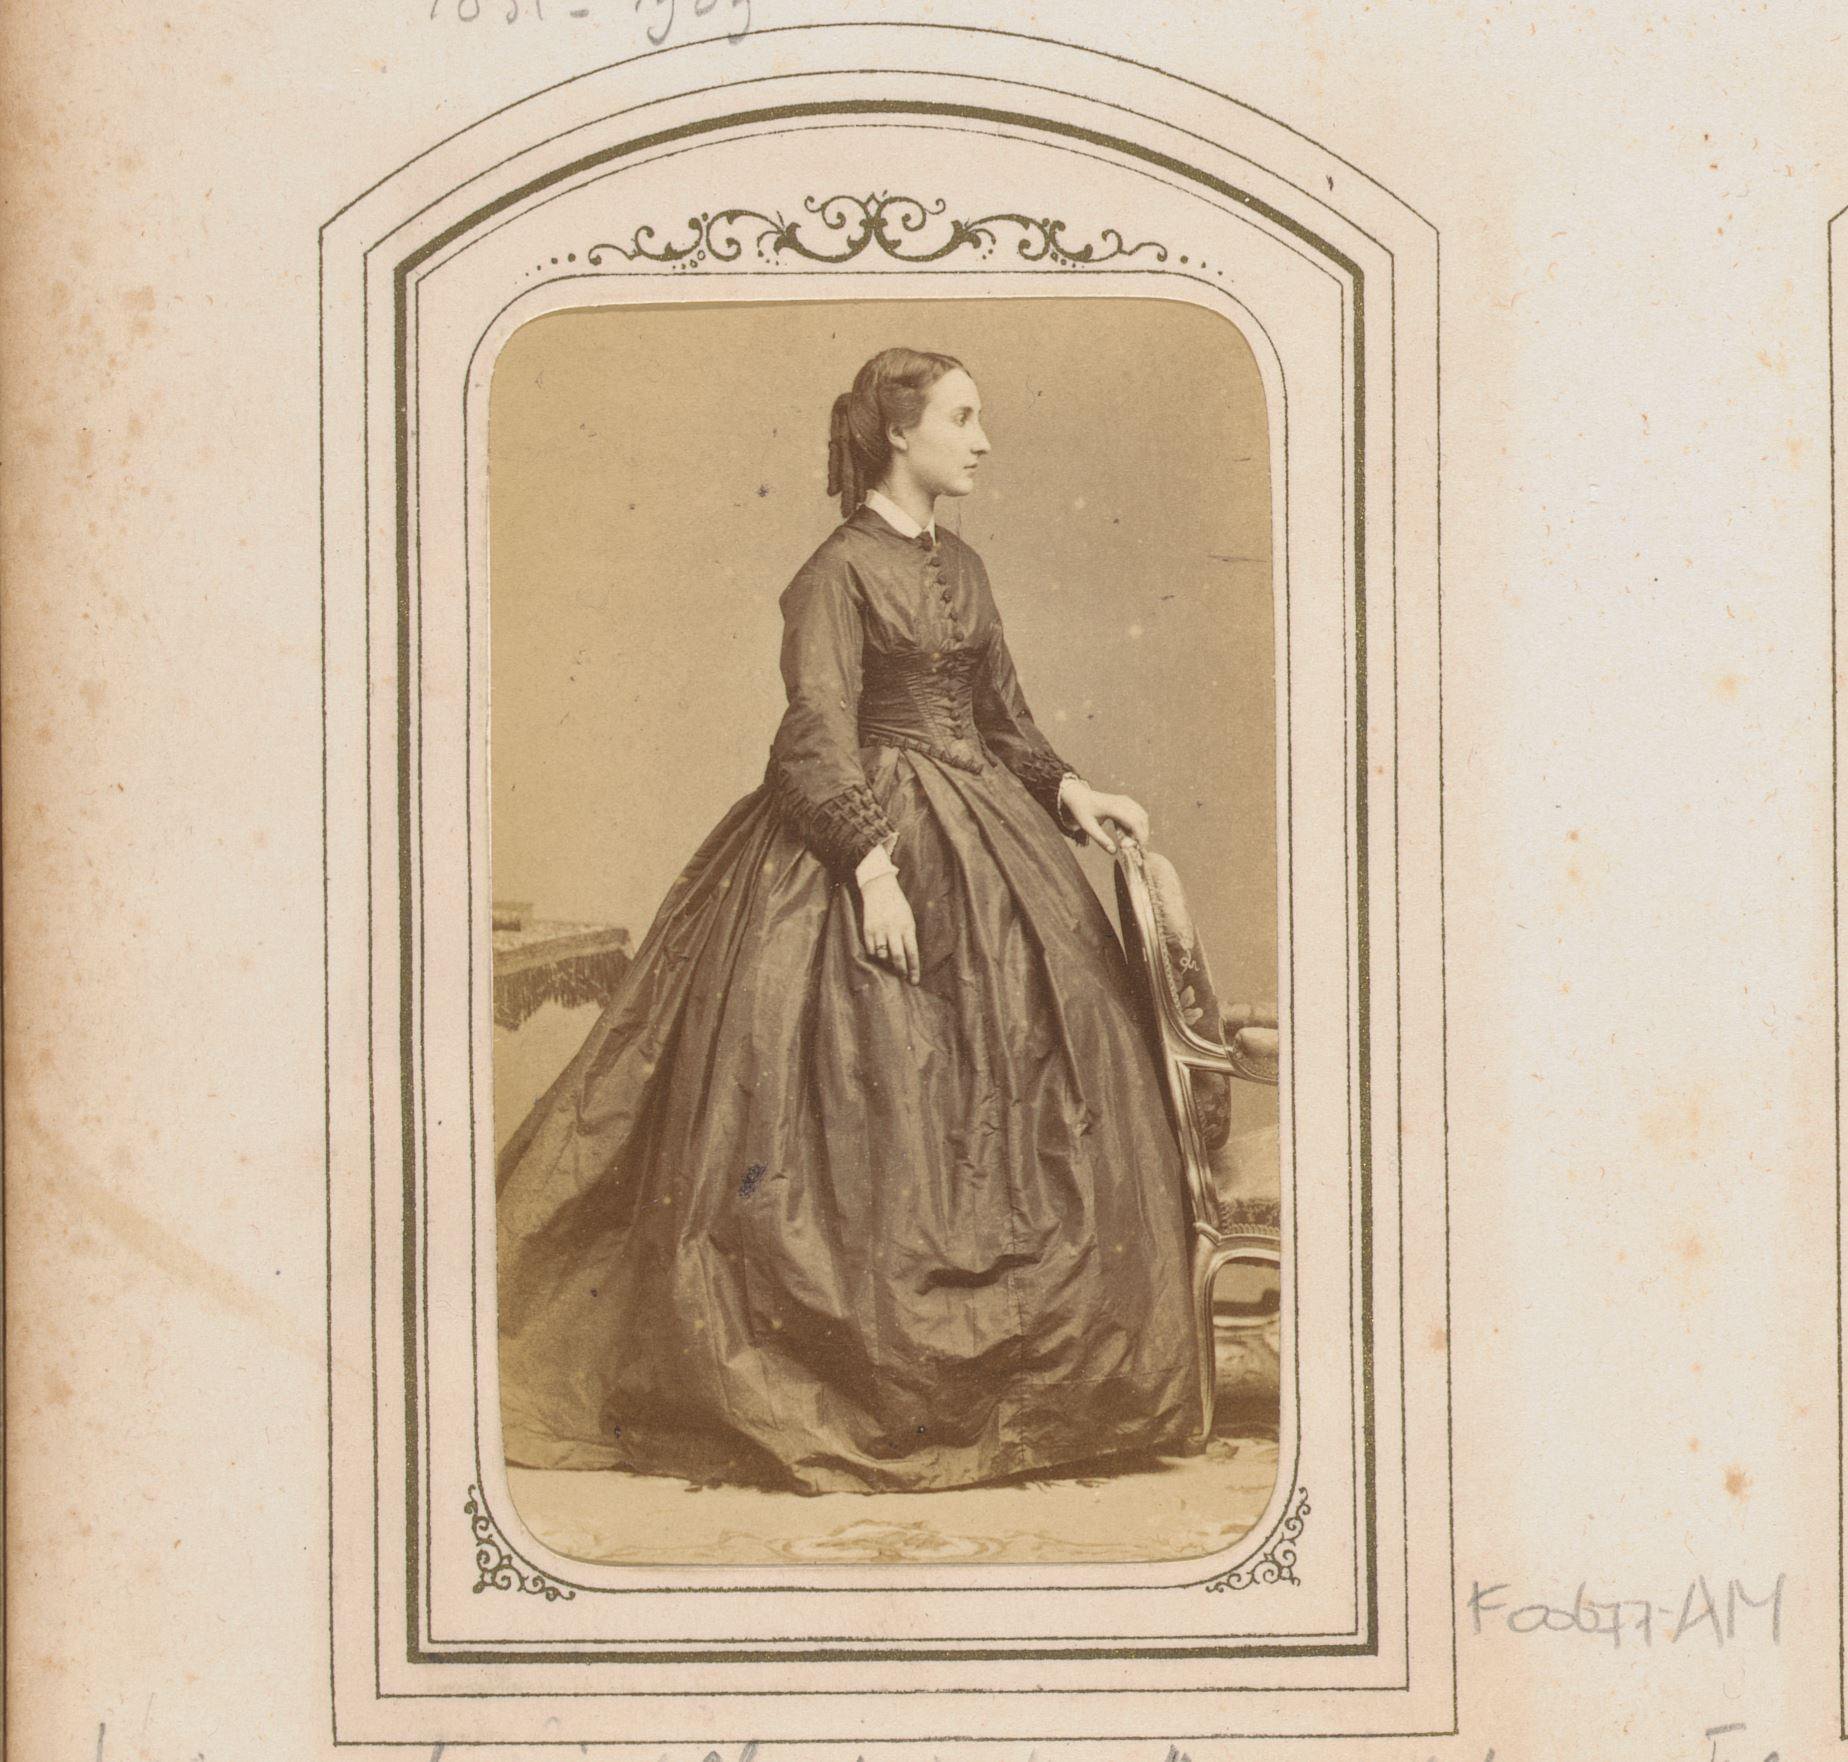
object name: album leaf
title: Portret van Charlotte van België, aartshertogin van Oostenrijk en keizerin van Mexico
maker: andré-adolphe-eugène disdéri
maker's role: fotograaf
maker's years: 1819-1889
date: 1855-1870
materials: cardboard, photographic support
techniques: albumen print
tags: laeken, historical persons - bb - woman, emperor - bb - female ruler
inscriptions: inscription: ‘Disdéri/ PARIS, 8, Boulevard des Italiens/ LONDON, Brook Street 70, 71, 72. HANOVER SQUARE W./ and for Equestrian Portraits,/ Hereford lodge, old Brompton Road, S.W.’, annotation: ‘Mexico’, number: ‘6 1/4’, annotation: ‘keizerin Maria-Charlotte van Mexico,geb/ prinses van België, dochter Leopold I/ foto Disderi (1840-1927)’, annotation: ‘impératrice du/ Mexique’